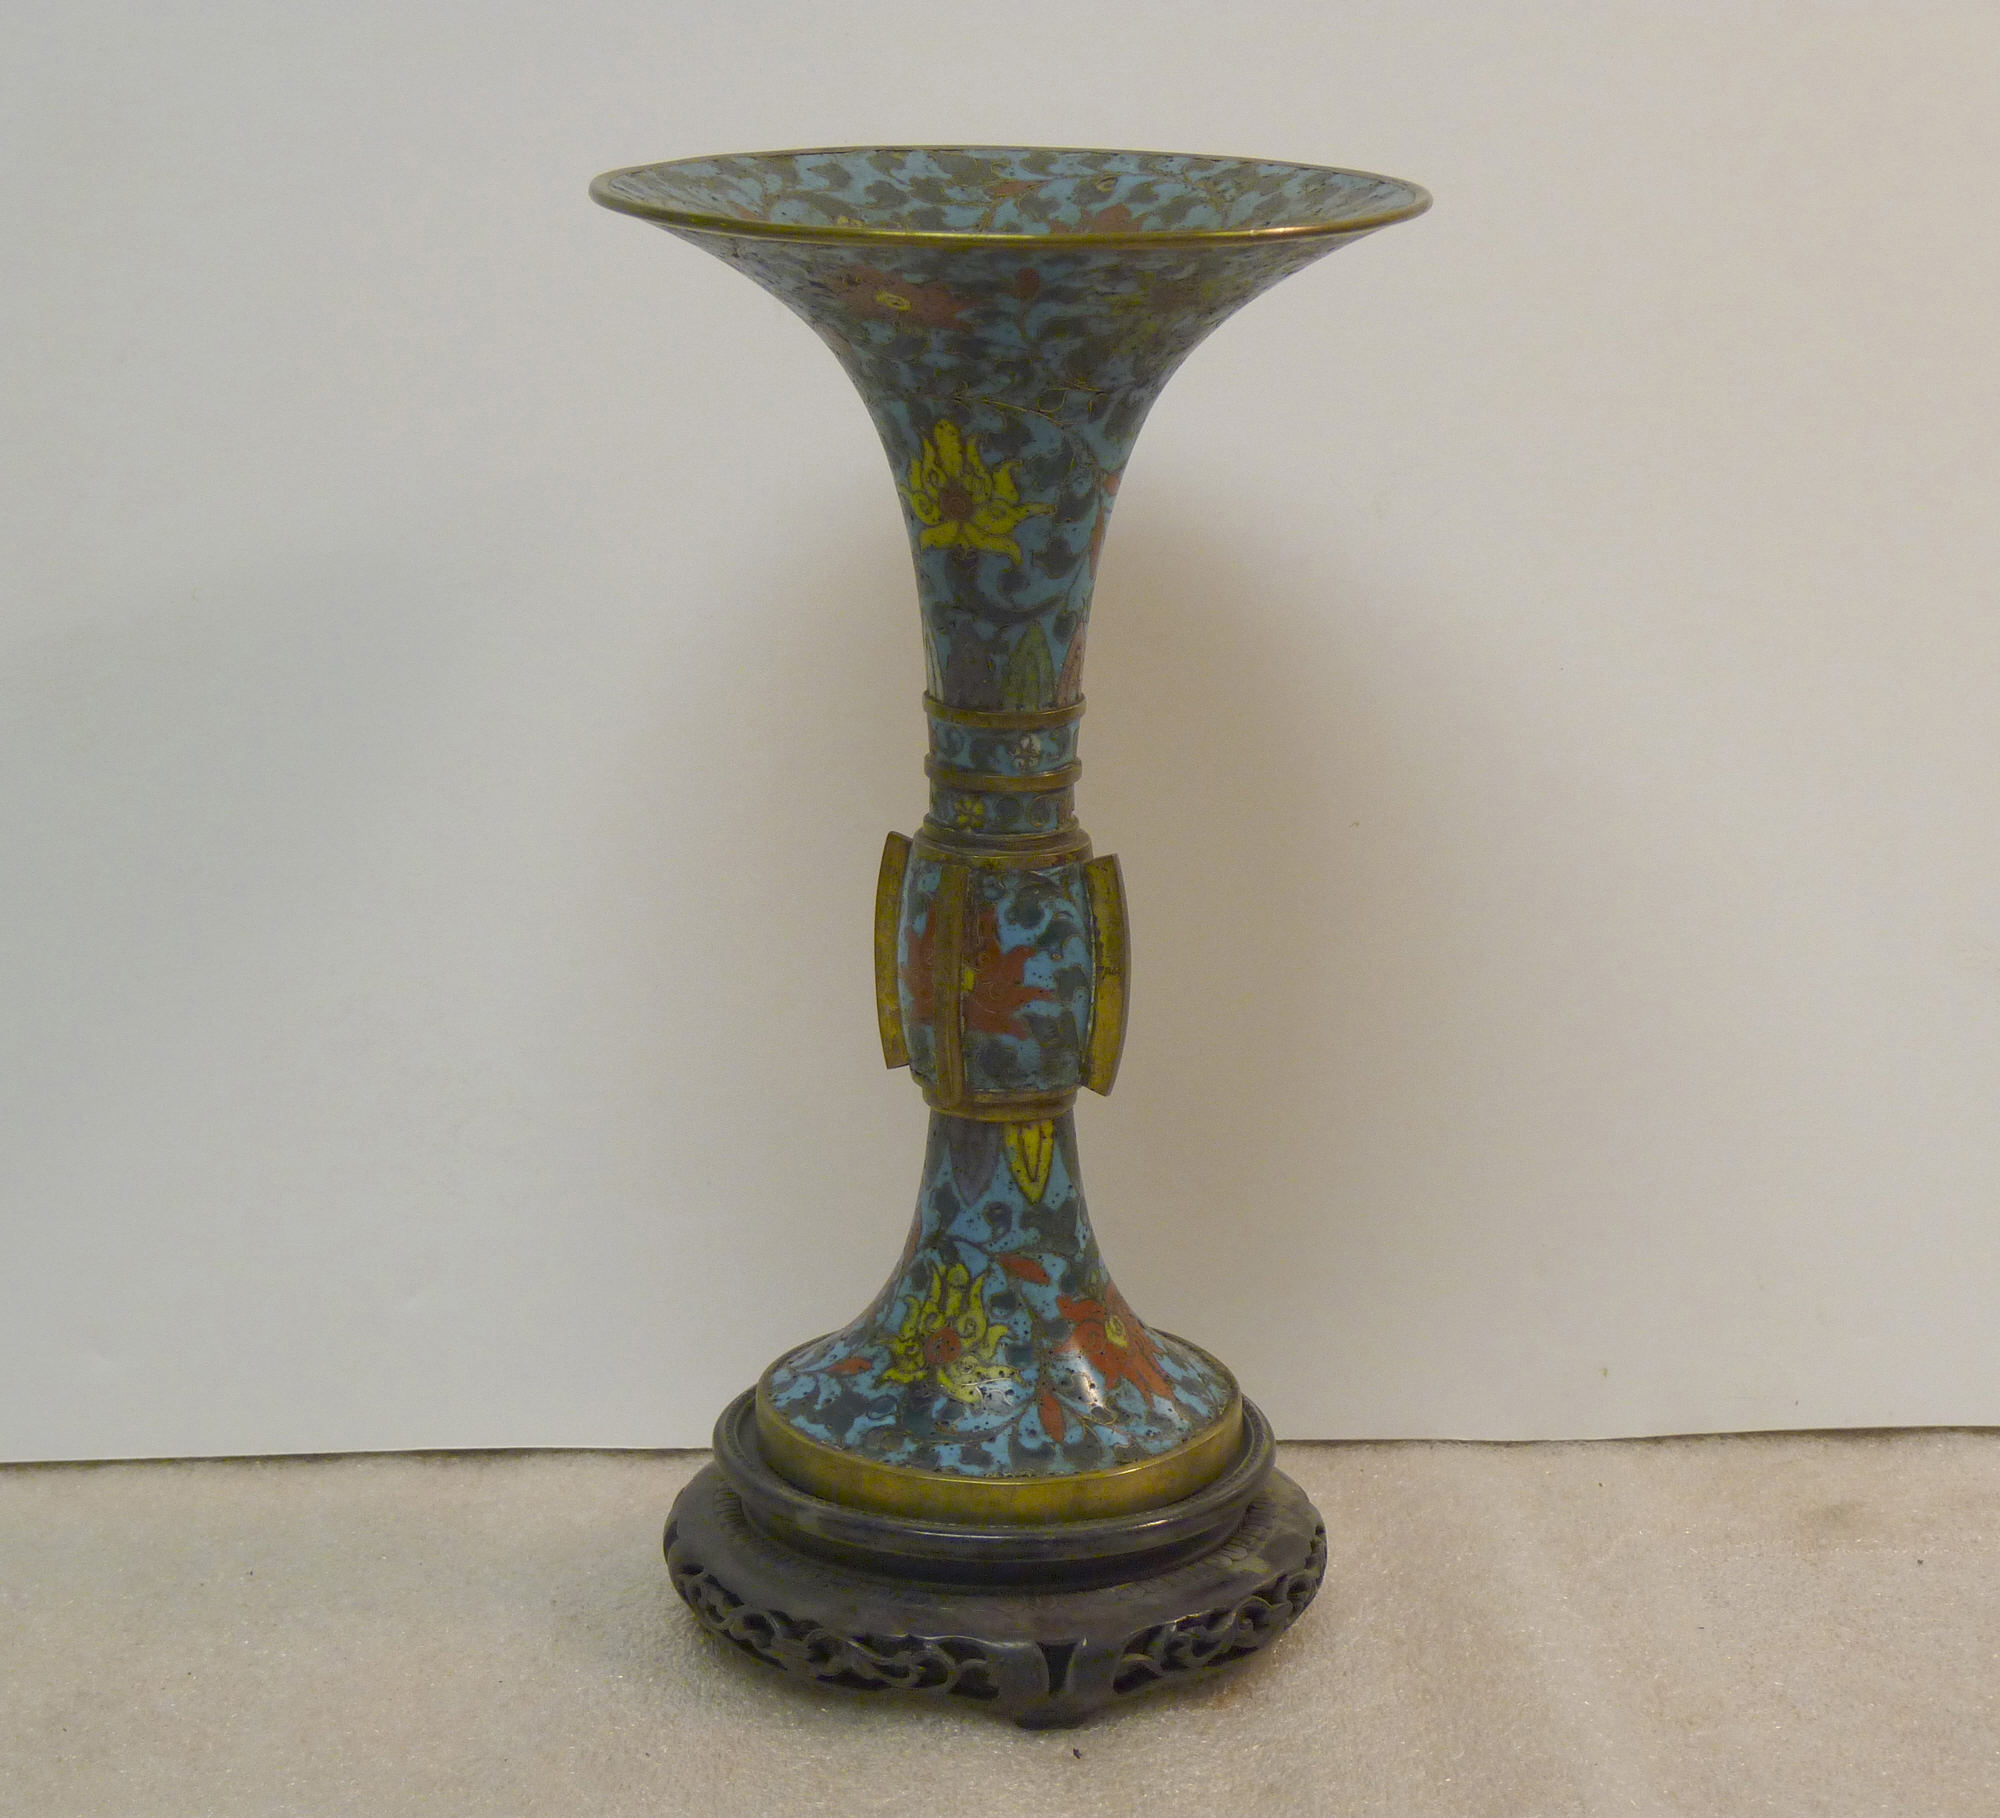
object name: vase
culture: chinese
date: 1368-1644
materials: enamel, copper gilt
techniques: enamel